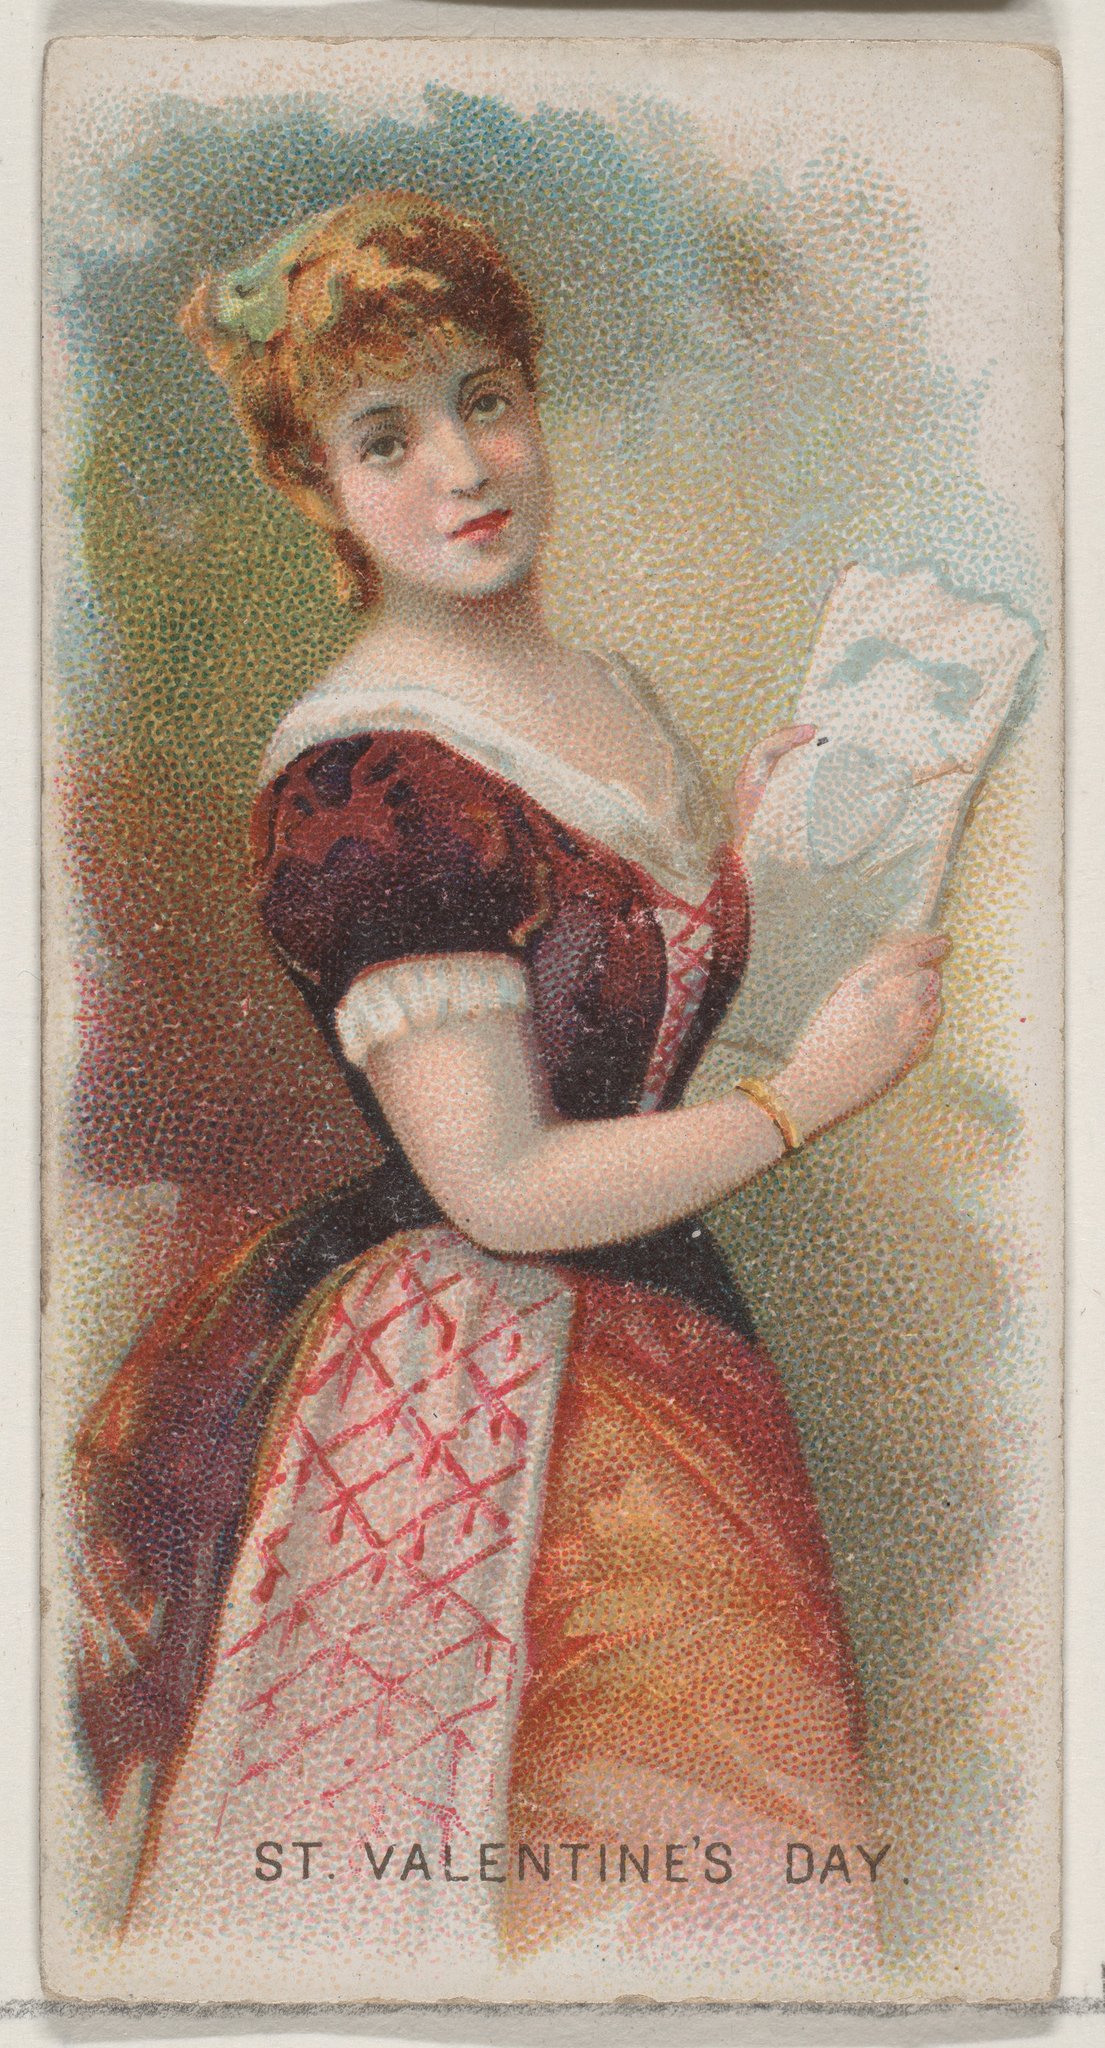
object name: print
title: Saint Valentine's Day, United States, from the Holidays series (N80) for Duke brand cigarettes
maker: w. duke, sons & co.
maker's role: publisher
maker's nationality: american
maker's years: 1870-1920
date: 1890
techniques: color lithograph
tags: women